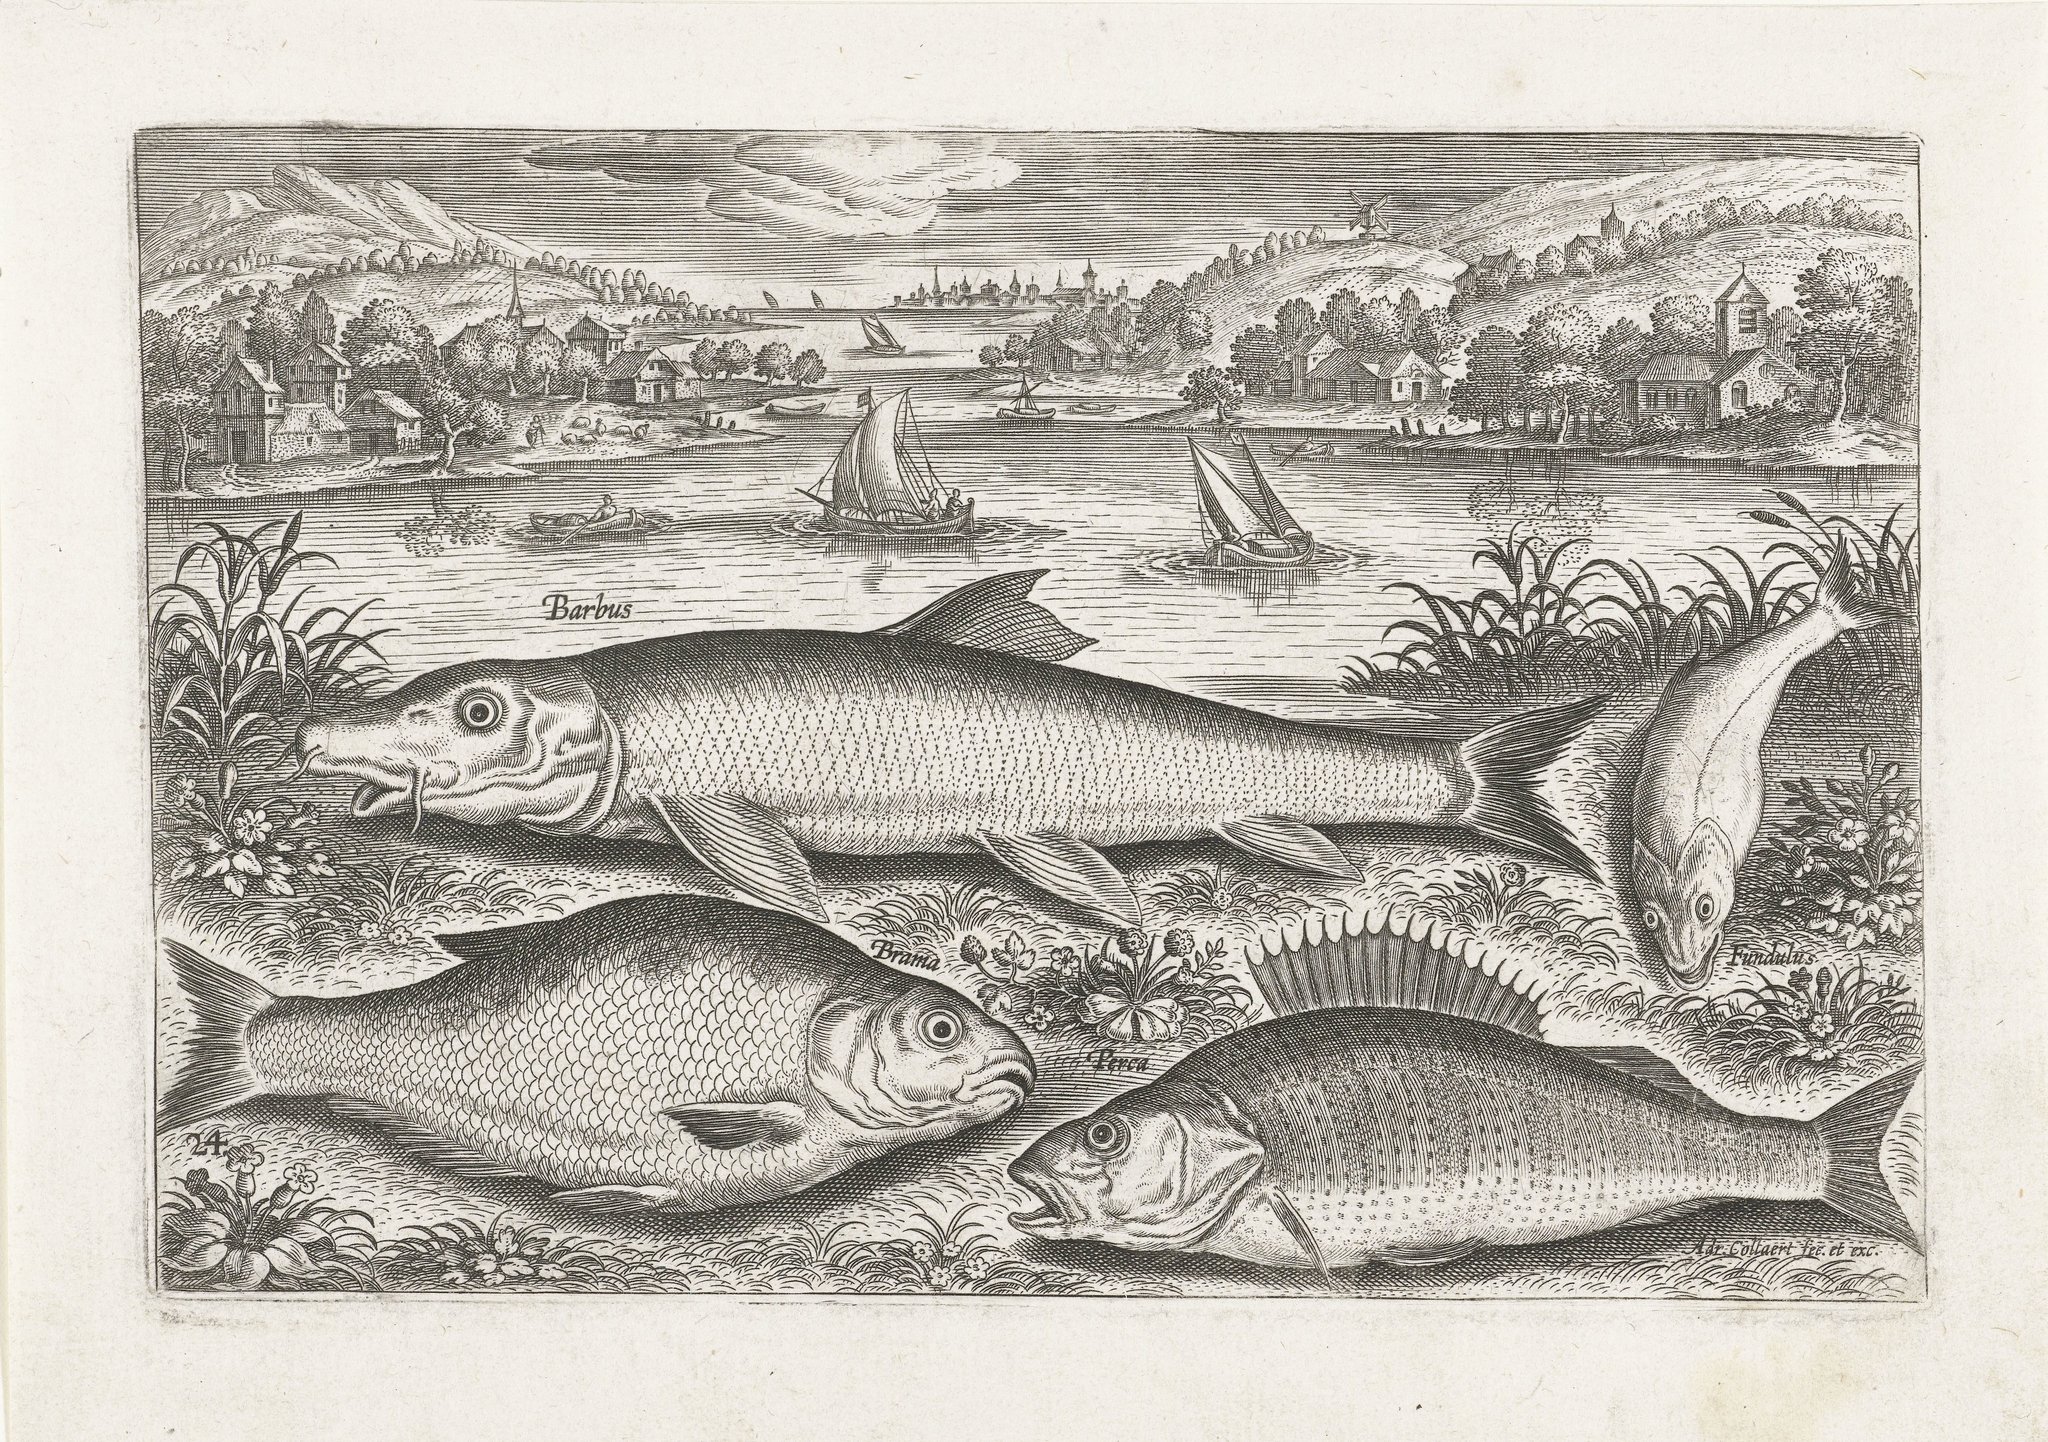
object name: print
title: Piscivm vivae icones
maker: adriaen collaert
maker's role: draughtsman, print maker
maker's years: 1560-1618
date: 1598-1618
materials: paper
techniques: engraving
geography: antwerp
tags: river, bony fishes: carp, bony fishes: bream, bony fishes: perch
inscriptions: collector's mark: Lugt 2228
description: Een baars, een barbeel, een brasum en een tandkarper liggen samen op de oever van een rivier. Op de achtergrond de rivier met enkele bootjes. De prent maakt deel uit van een serie met vissen als onderwerp.